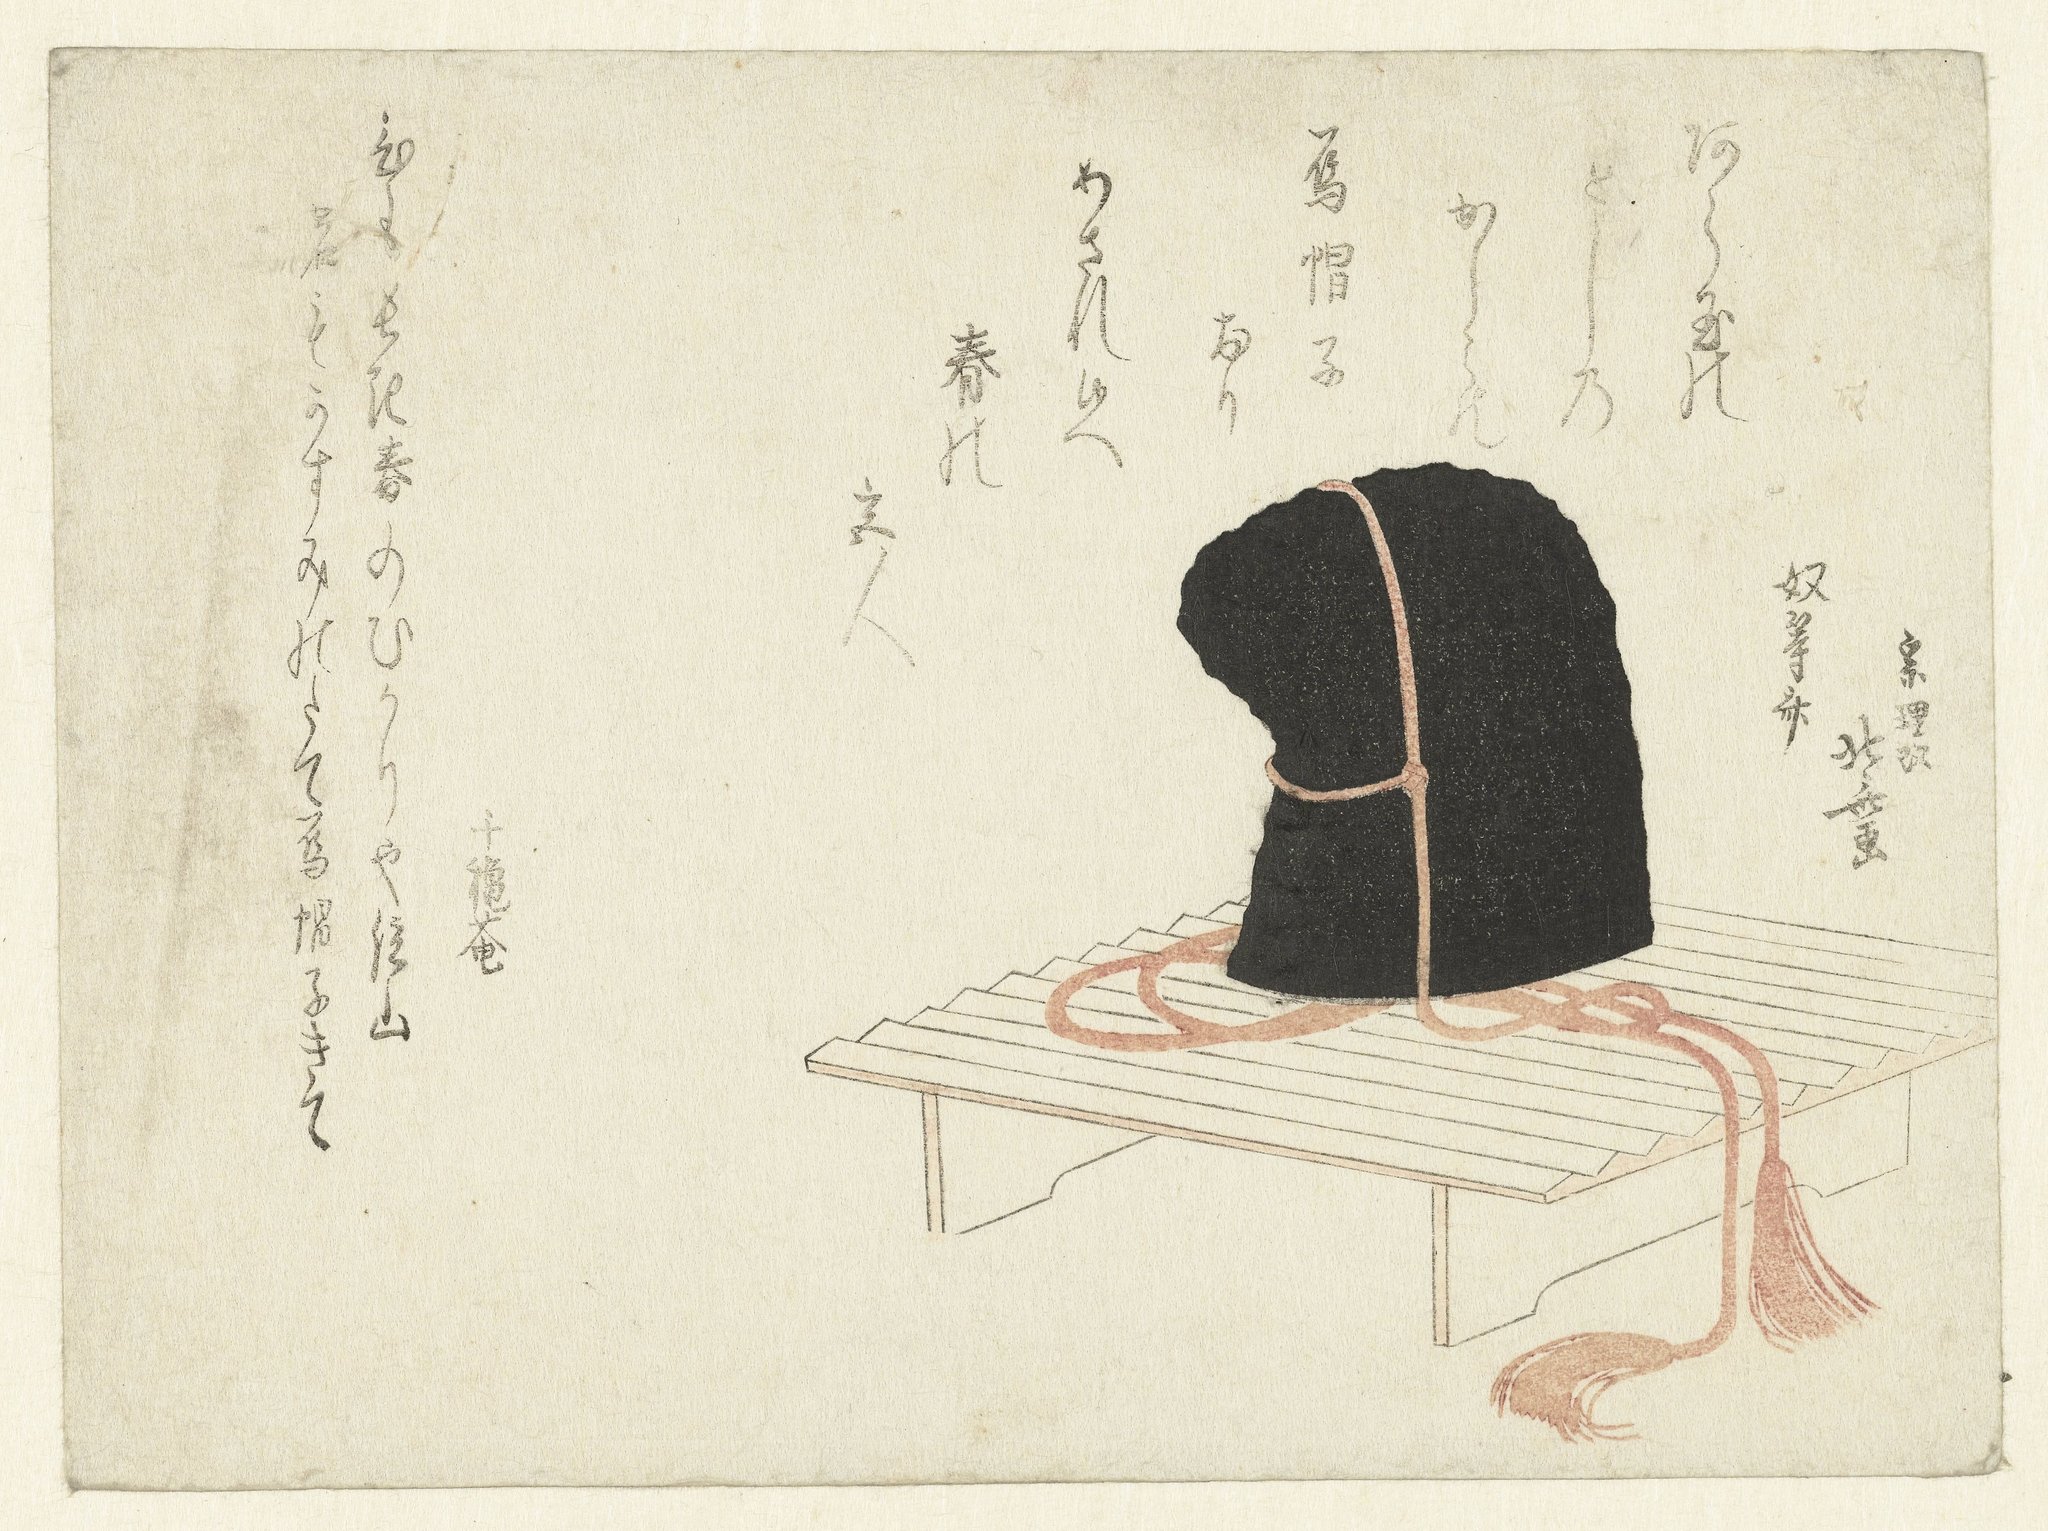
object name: print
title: A Court-cap on a Stand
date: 1799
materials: paper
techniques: blind stamped, woodcut, polish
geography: japan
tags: head-gear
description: Een surimono is een luxe uitgevoerde prent waarop beeld met één of meerdere gedichten gecombineerd is. Bij het drukken van een surimono werd vaak gebruik gemaakt van dikker papier, blinddruk en metaal pigmenten, zoals koper- en zilverpoeder. De prenten werden vaak in opdracht van dichters gemaakt en als exclusief geschenk aan vrienden en relaties gegeven.